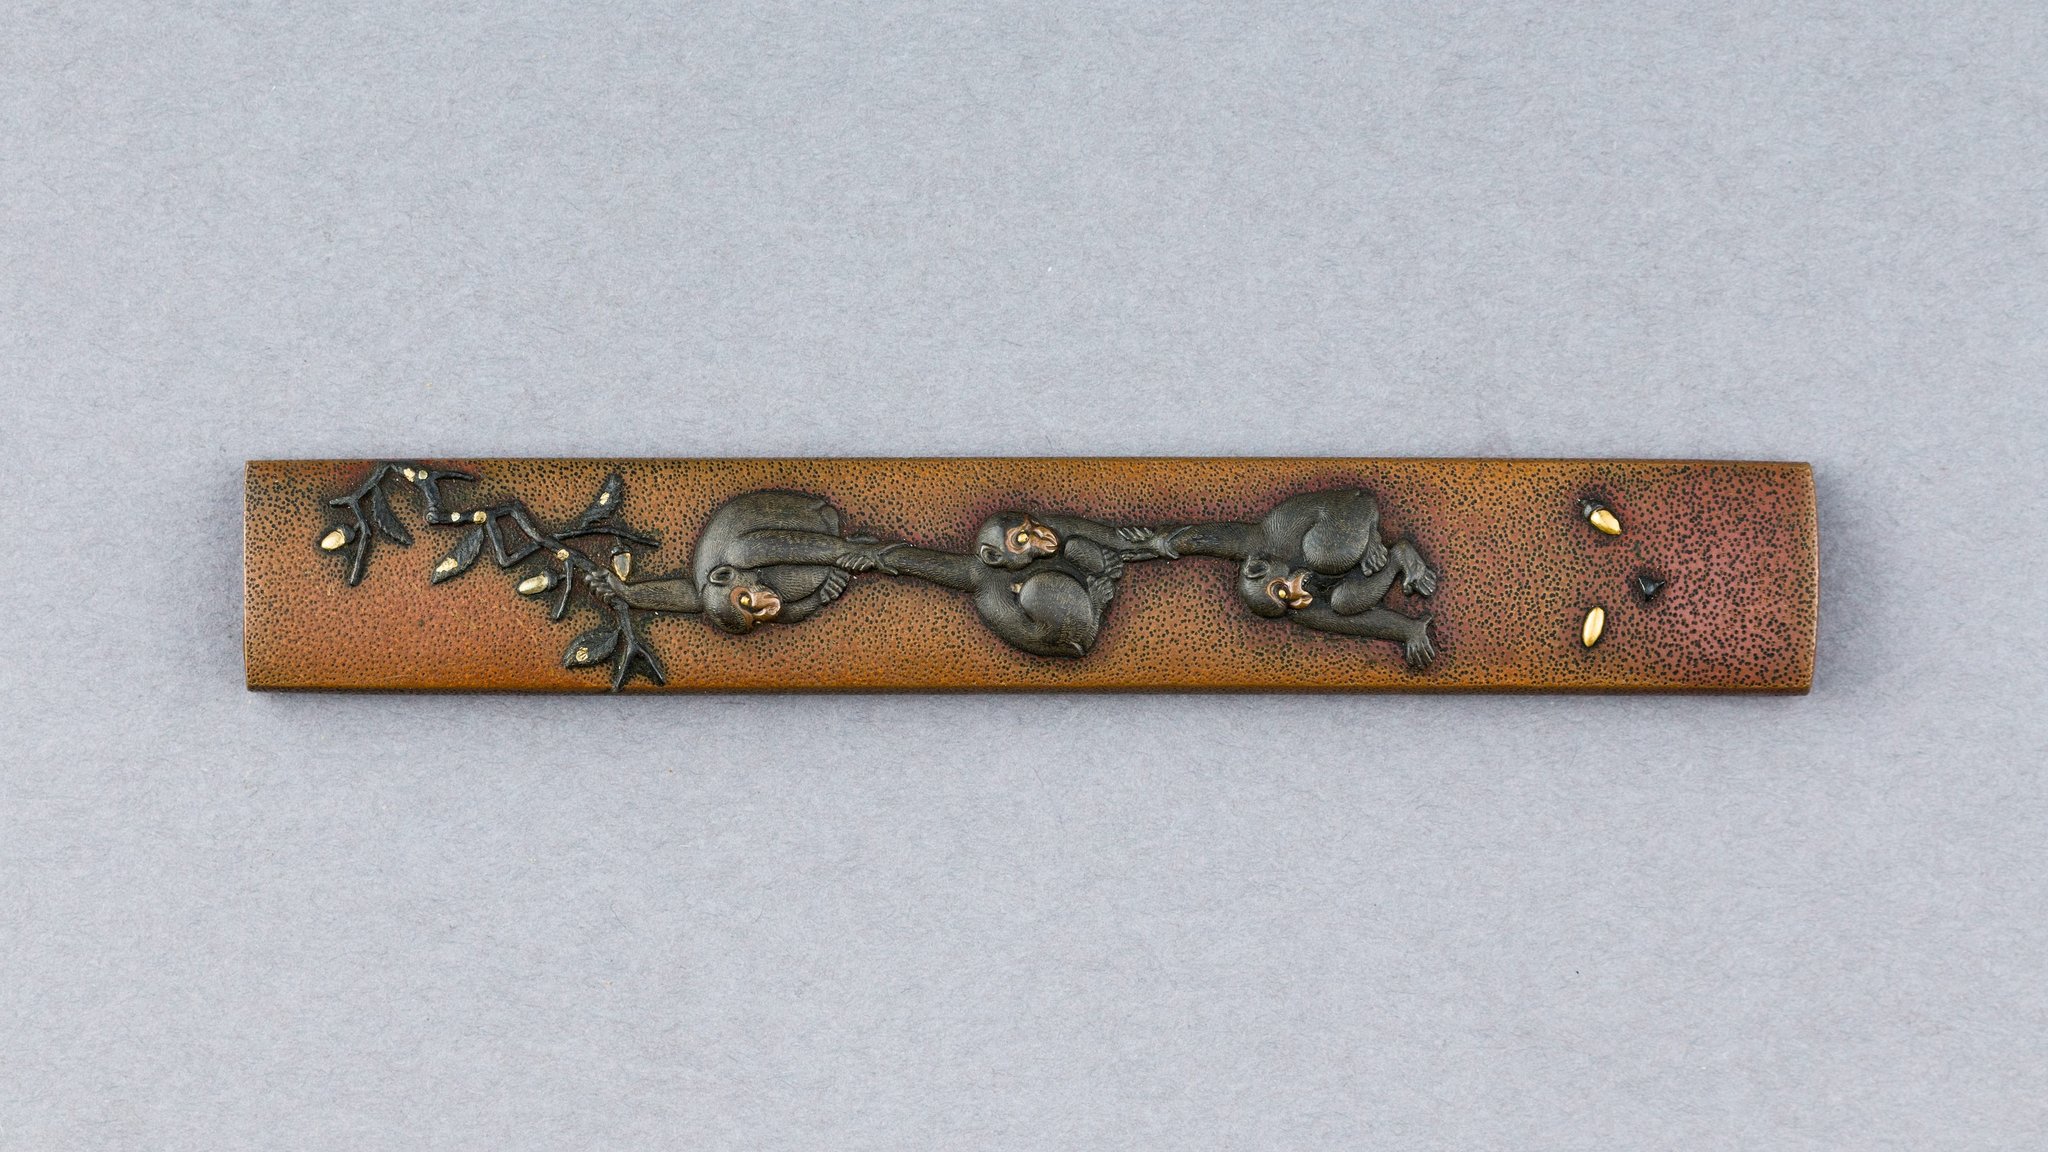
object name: knife handle kozuka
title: Knife Handle (Kozuka)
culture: japanese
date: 1615-1868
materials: copper, gold, silver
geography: japan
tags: monkeys